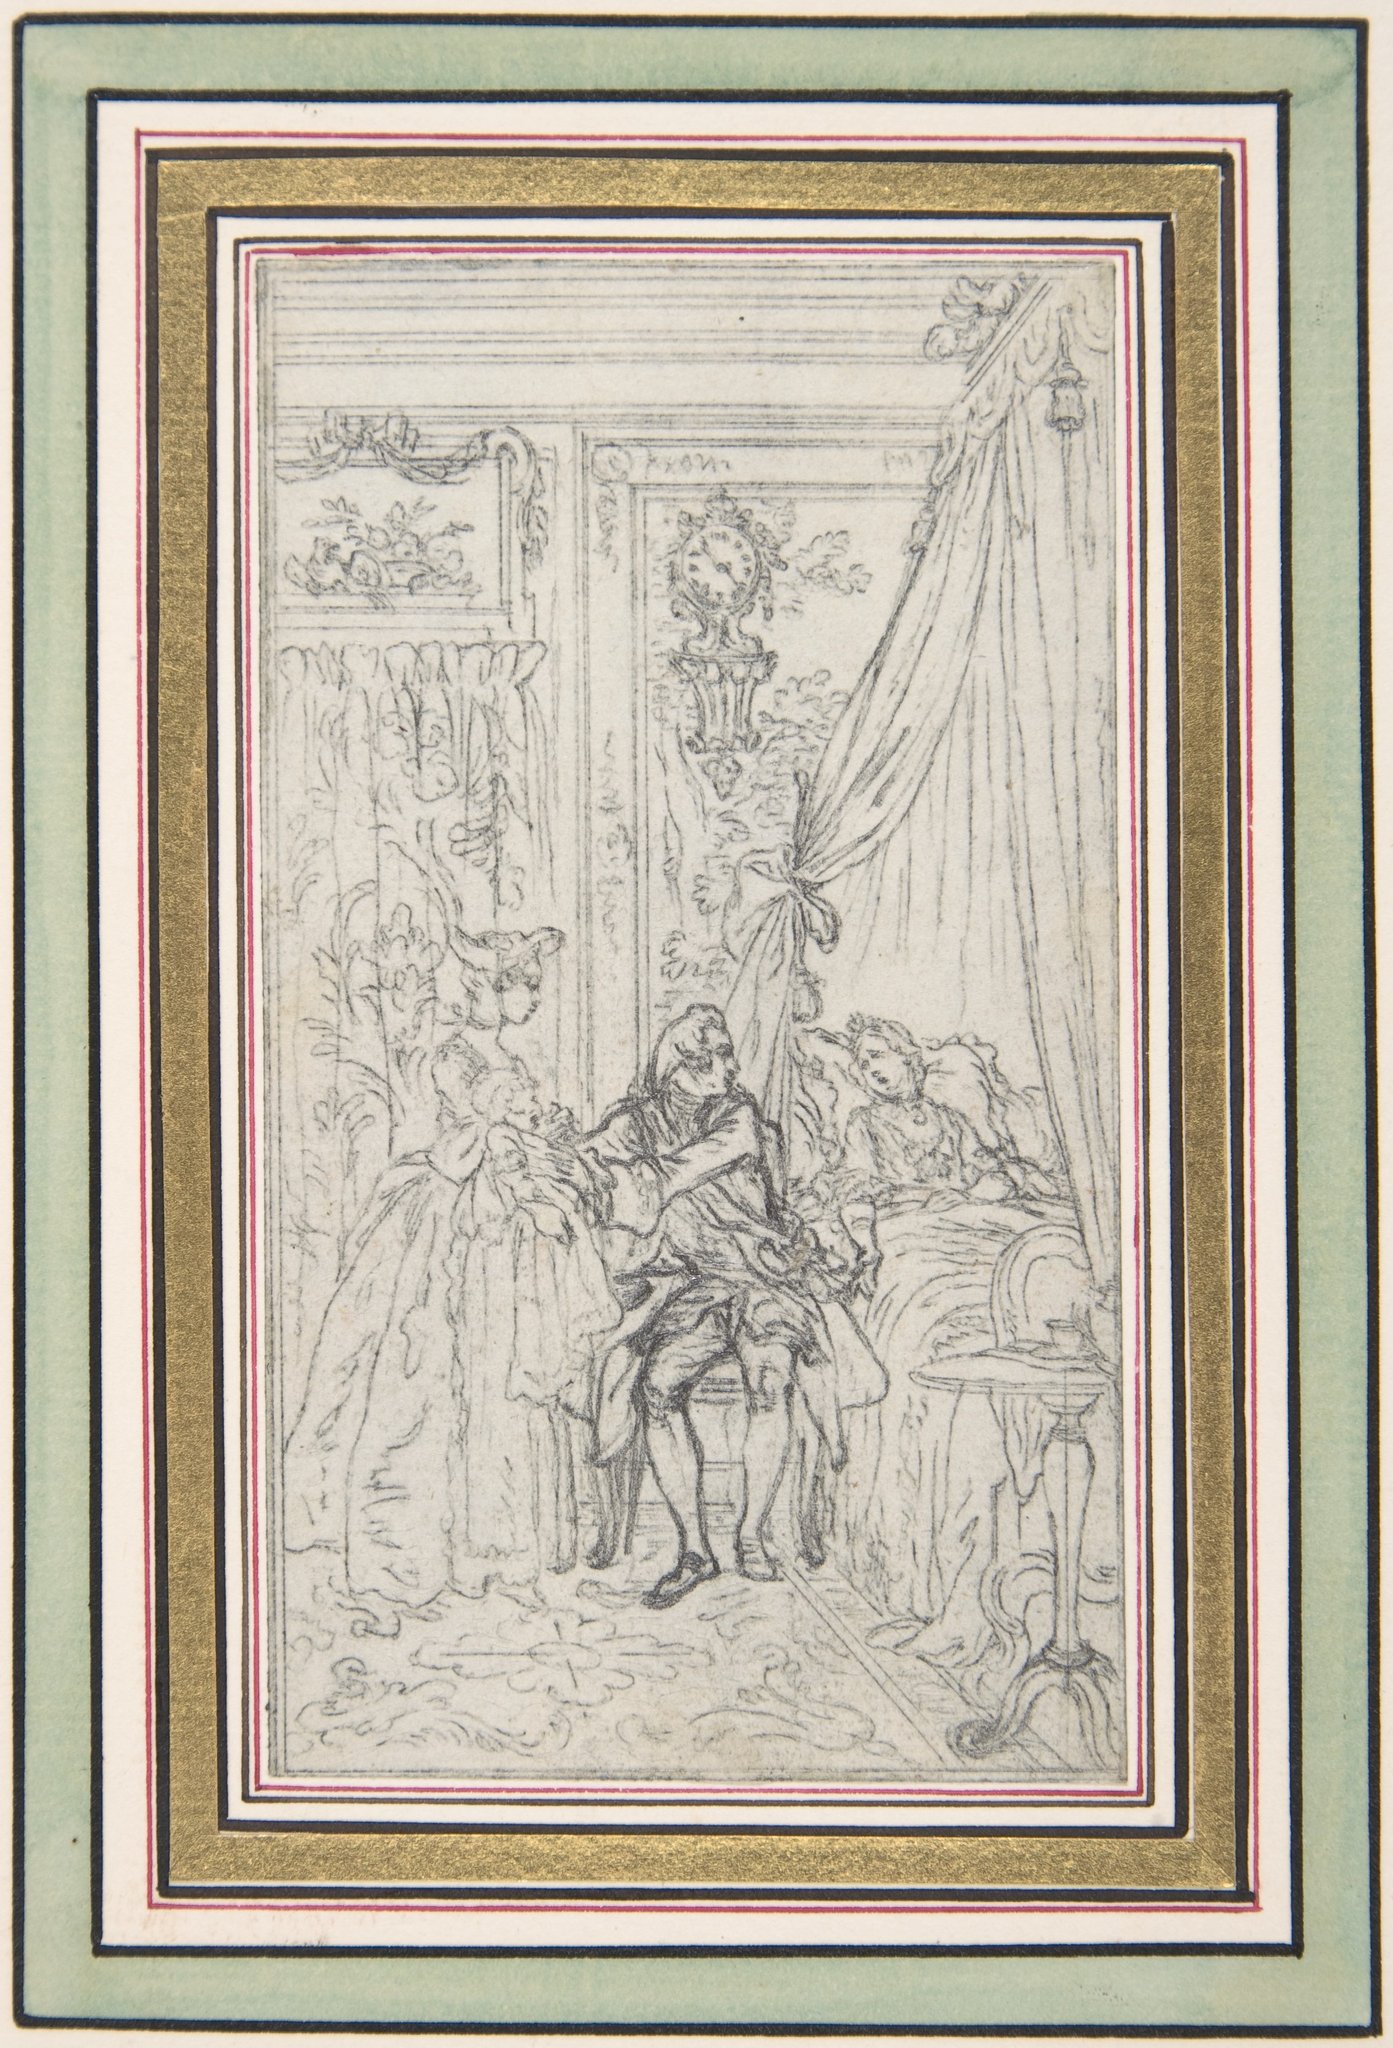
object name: drawing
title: Study for a frontispiece for "Histoire de Miss Jenny"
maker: hubert françois gravelot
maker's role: artist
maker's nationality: french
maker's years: 1699-1773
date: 1701-1800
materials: chalk, graphite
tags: bedrooms,men,women